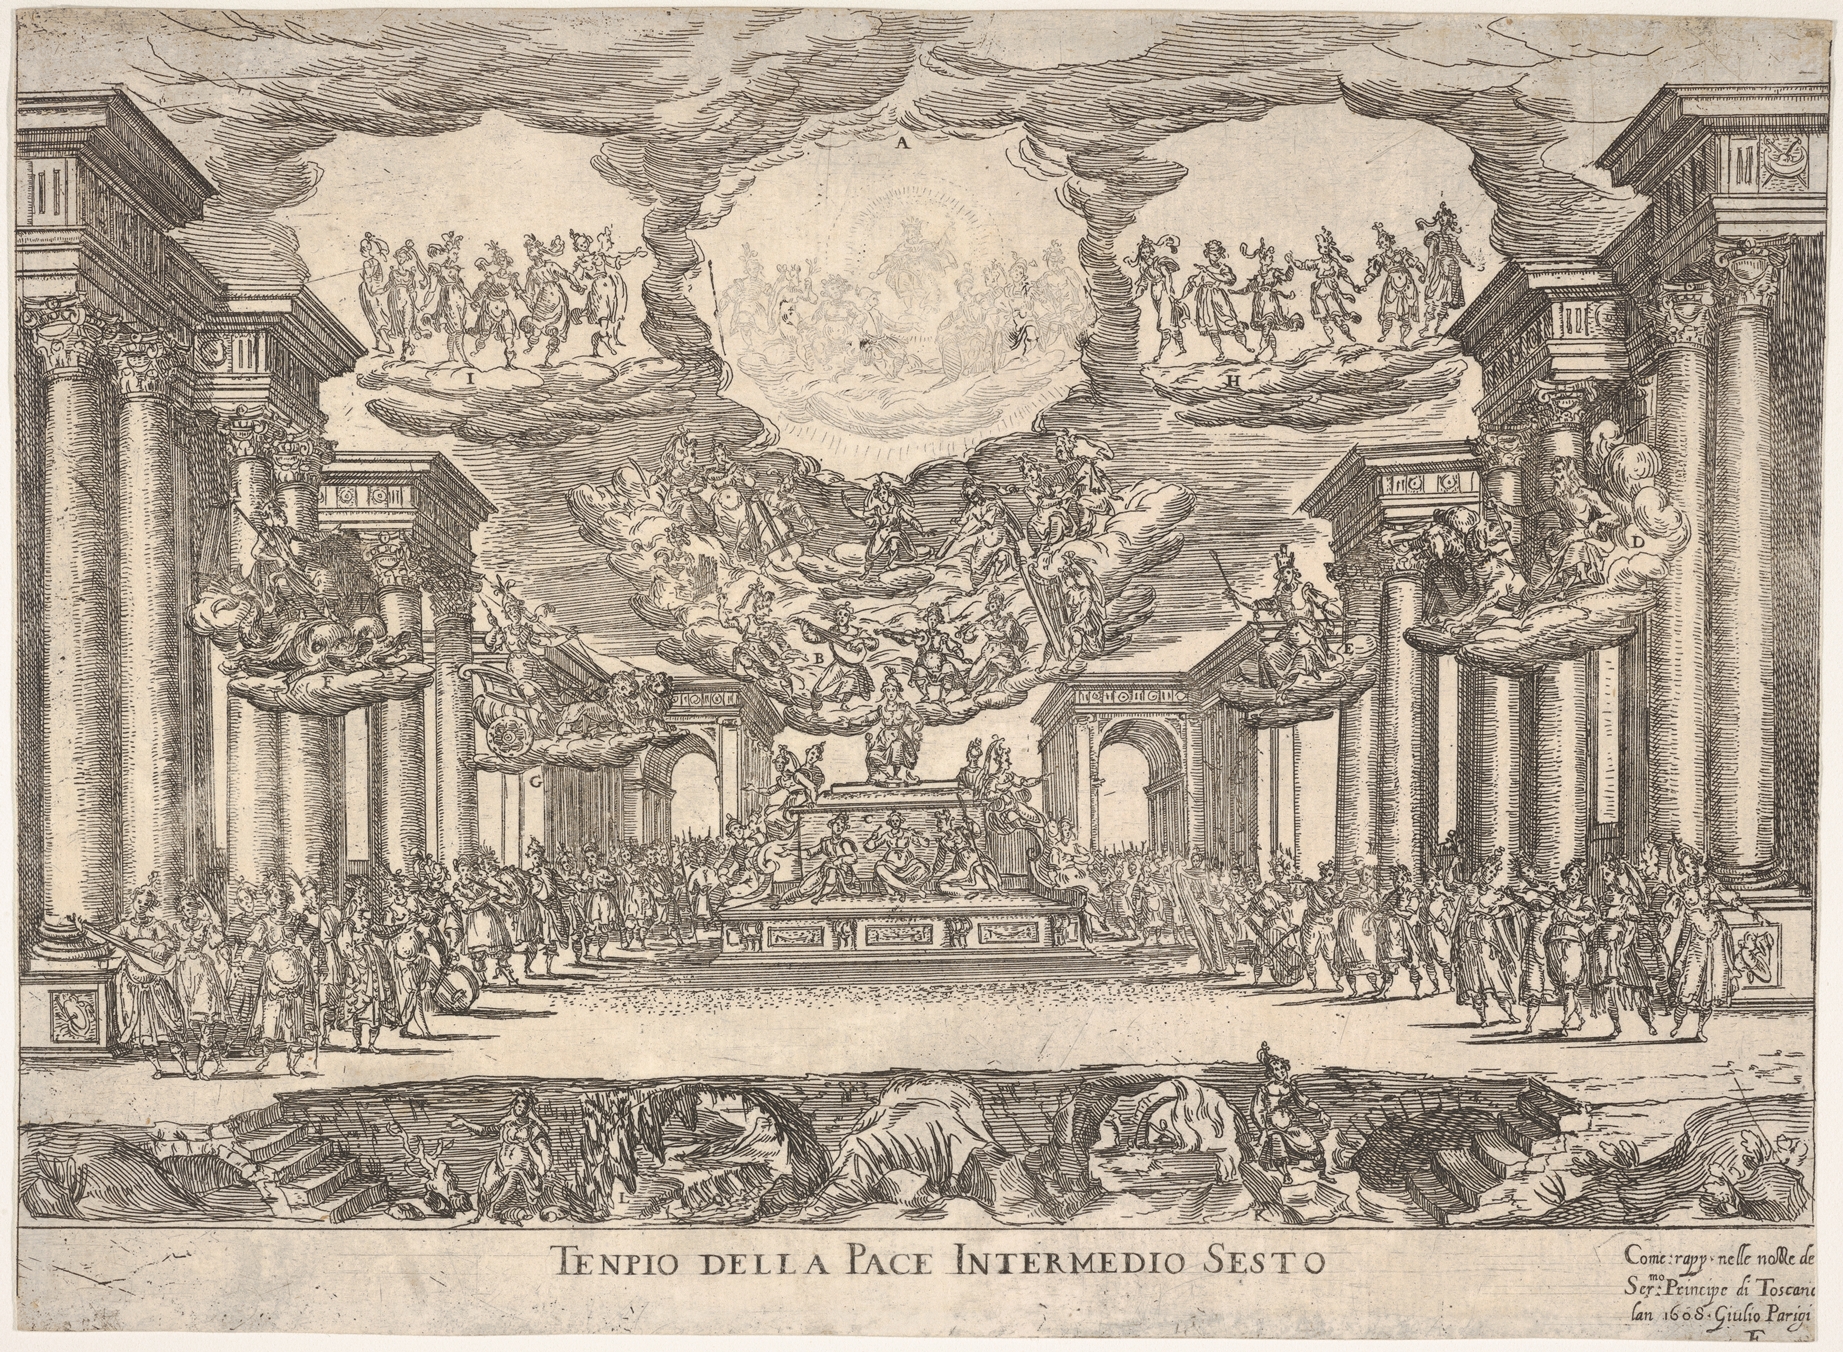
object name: print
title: Sixth interlude: temple of peace (Intermedio sesto: tempio della pace), from "Seven Interludes for the wedding celebration of Cosimo de' Medici in Florence, 1608"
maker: remigio cantagallina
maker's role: artist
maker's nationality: italian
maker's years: 1582-1656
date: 1608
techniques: etching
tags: human figures,dancing